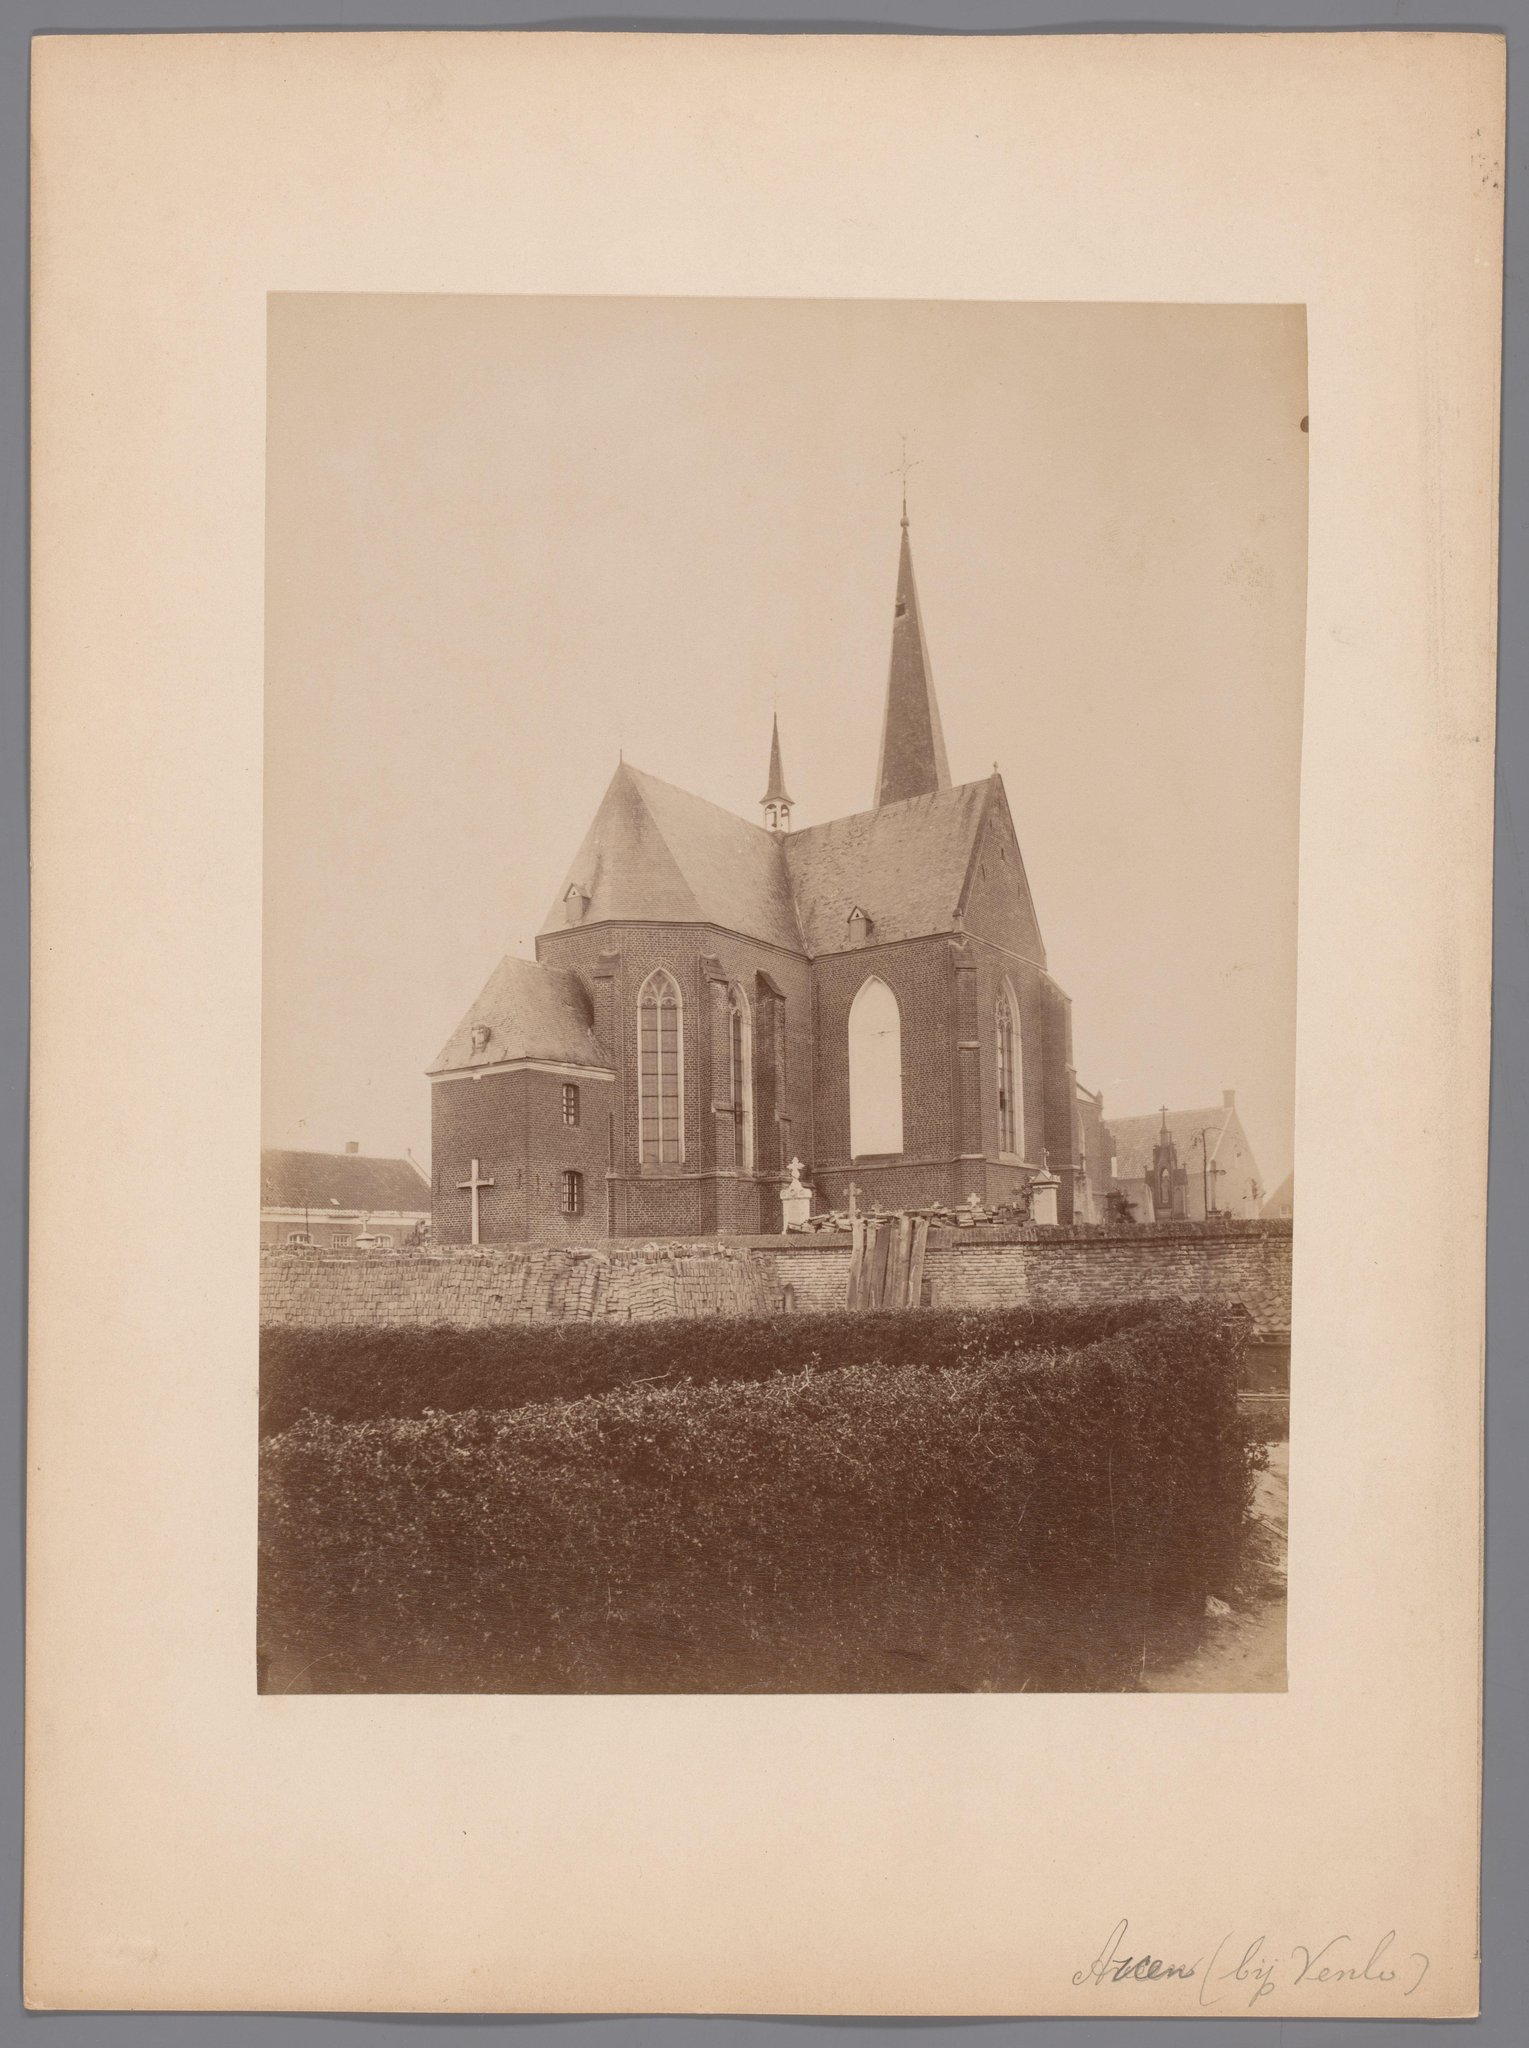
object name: photograph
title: Gezicht op de Rooms-Katholieke Kerk te Arcen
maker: anoniem (monumentenzorg)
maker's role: fotograaf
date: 1892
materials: cardboard, photographic support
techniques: albumen print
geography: arcen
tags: church (exterior)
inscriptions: annotation: ‘R.K. kerk te Arcen bij Venlo/ April 1892’, annotation: ‘Arcen (bij Venlo)’